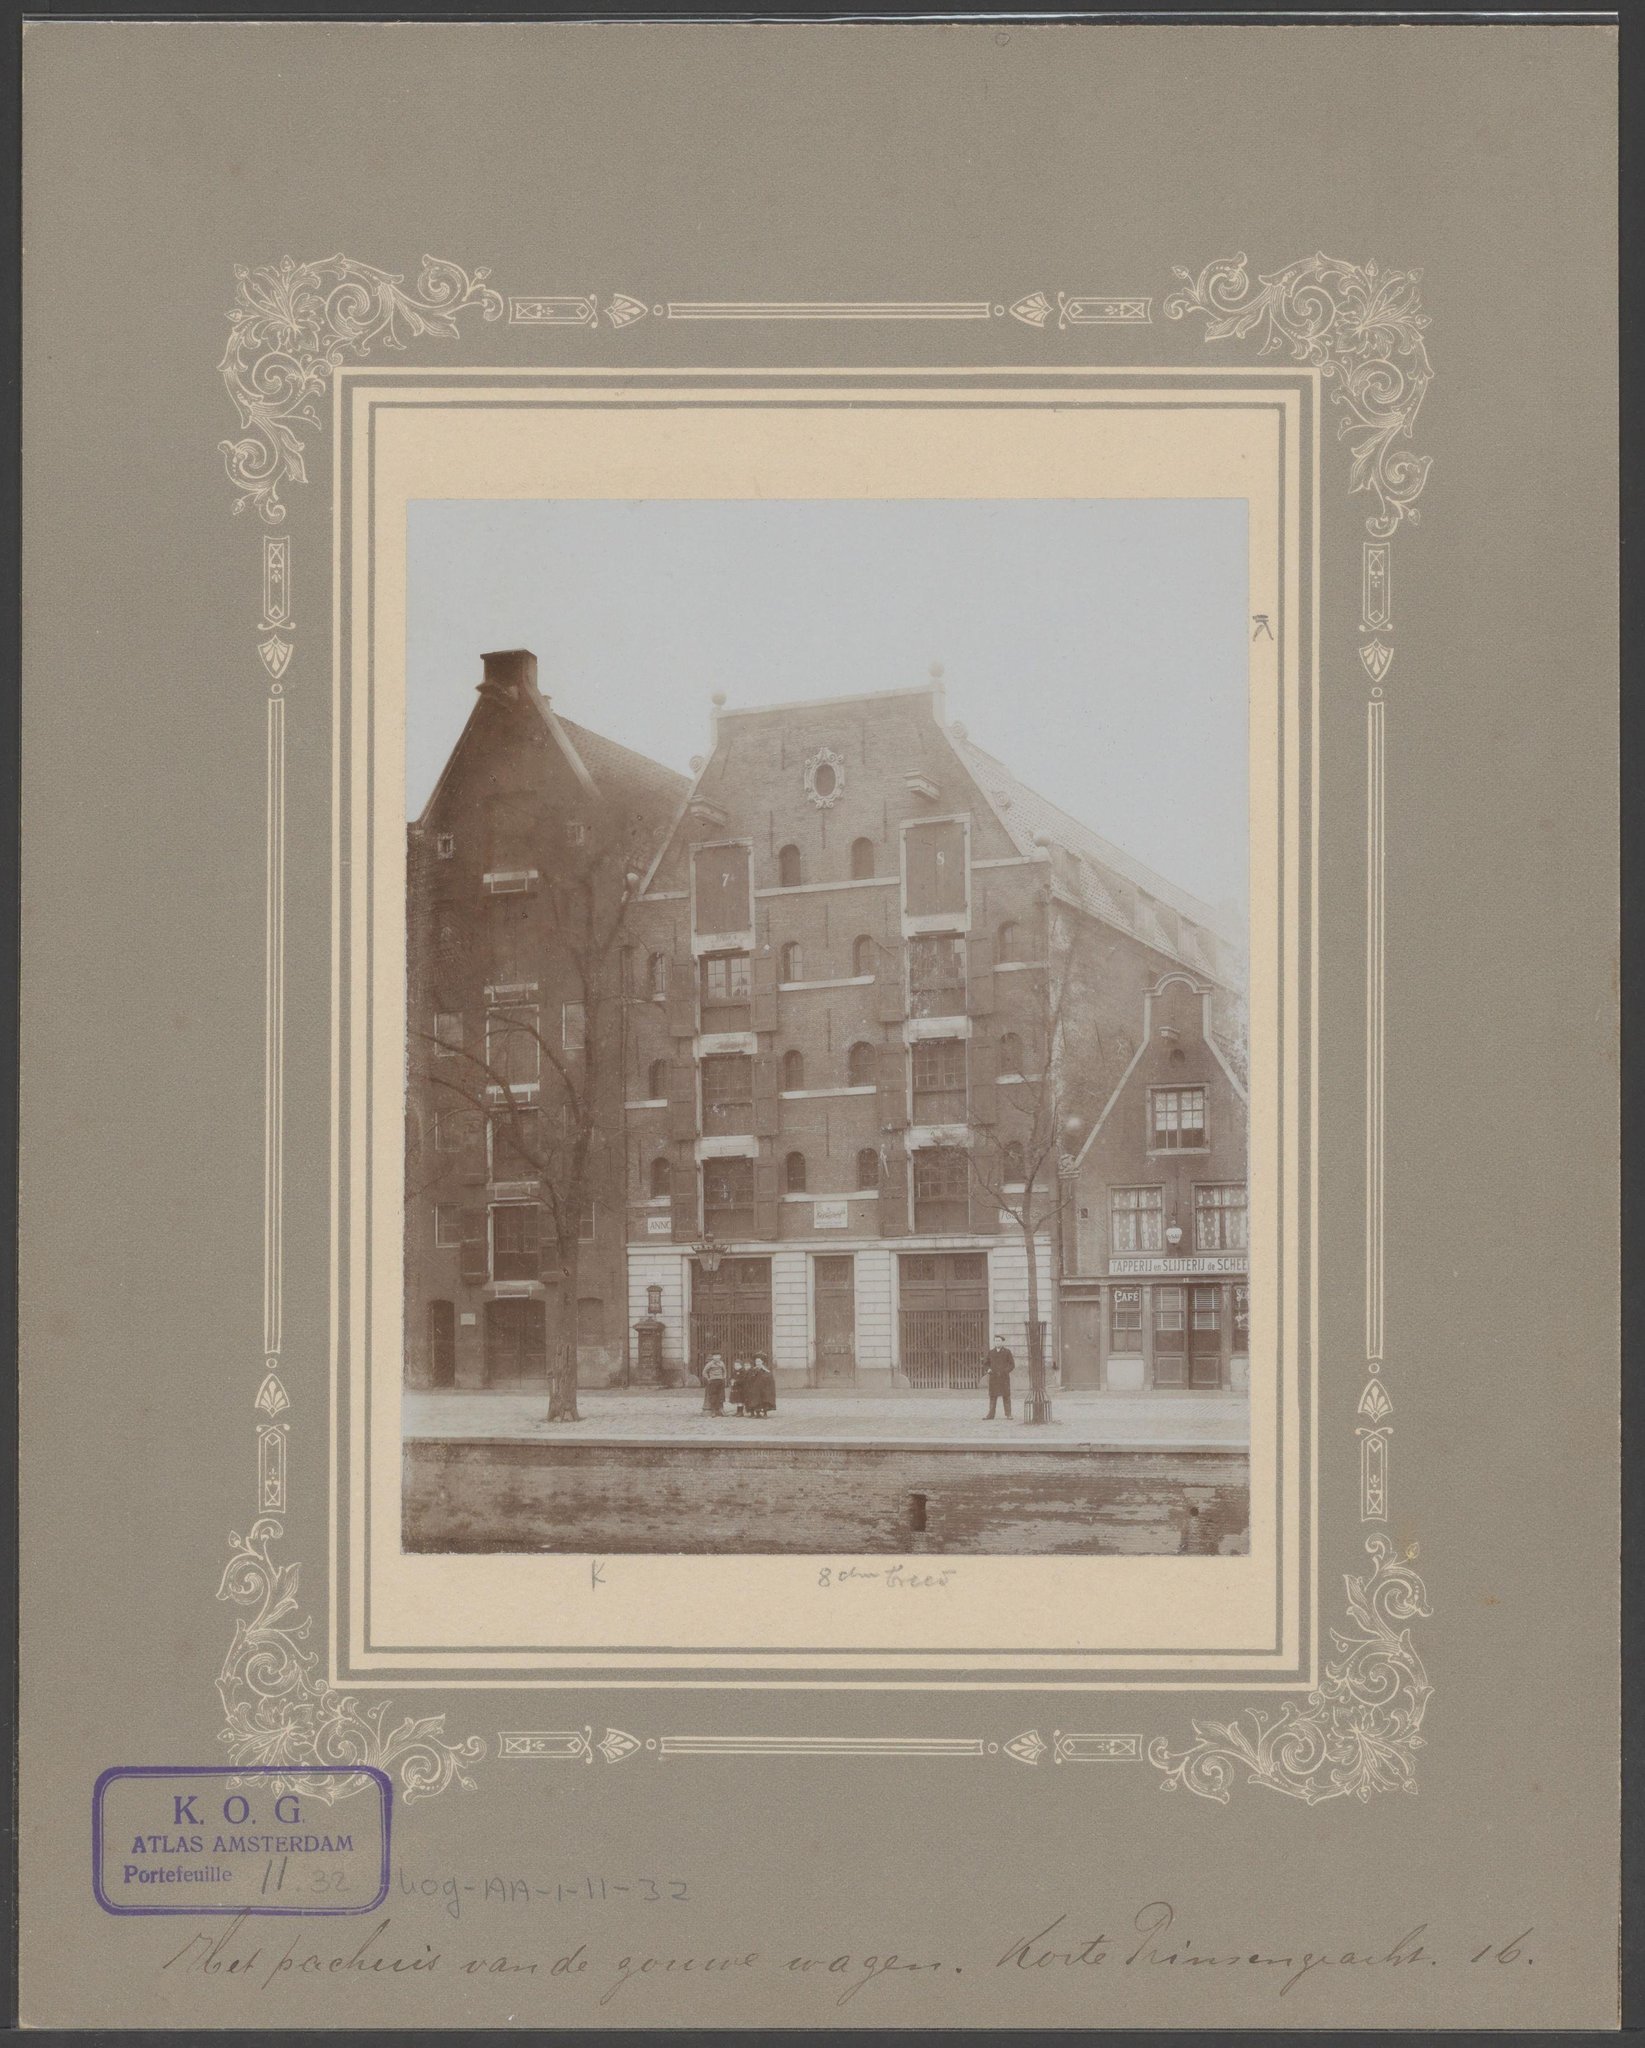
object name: print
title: Gezicht op een pakhuis aan de Korte Prinsengracht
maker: Anonymous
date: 1865-1940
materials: paper, cardboard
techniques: lithograph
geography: amsterdam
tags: large-scale structure for storage, e.g.: warehouse, depot, silo, city-view in general; 'veduta', canal, façade (of house or building), street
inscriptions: collector's mark: ‘11.32’ Lugt 1641b, inscription: ‘Het pachuis van de gouwe wagen. Korte Prinsengracht. 16.’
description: Onderwerpsrubriek binnen de Atlas Amsterdam: Prinsengracht, Korte Prinsengracht, Prins Hendrikkade. Zie ook Portefeuille 1: gezichten van het IJ op de stad.